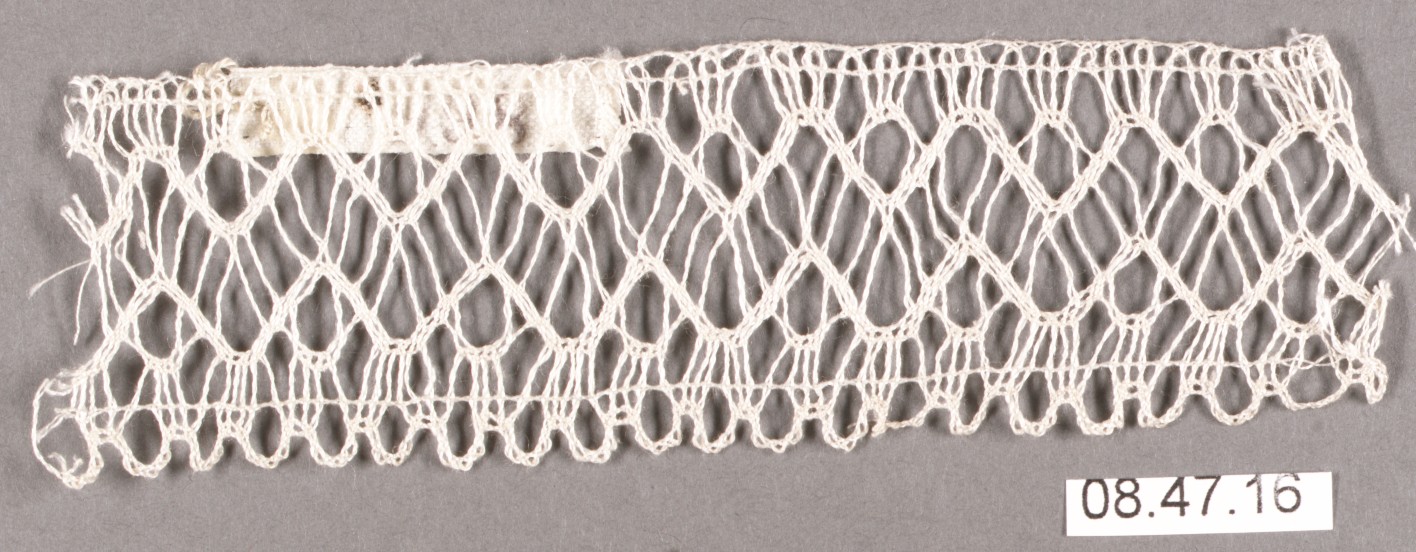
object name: fragment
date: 1801-1900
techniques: lace